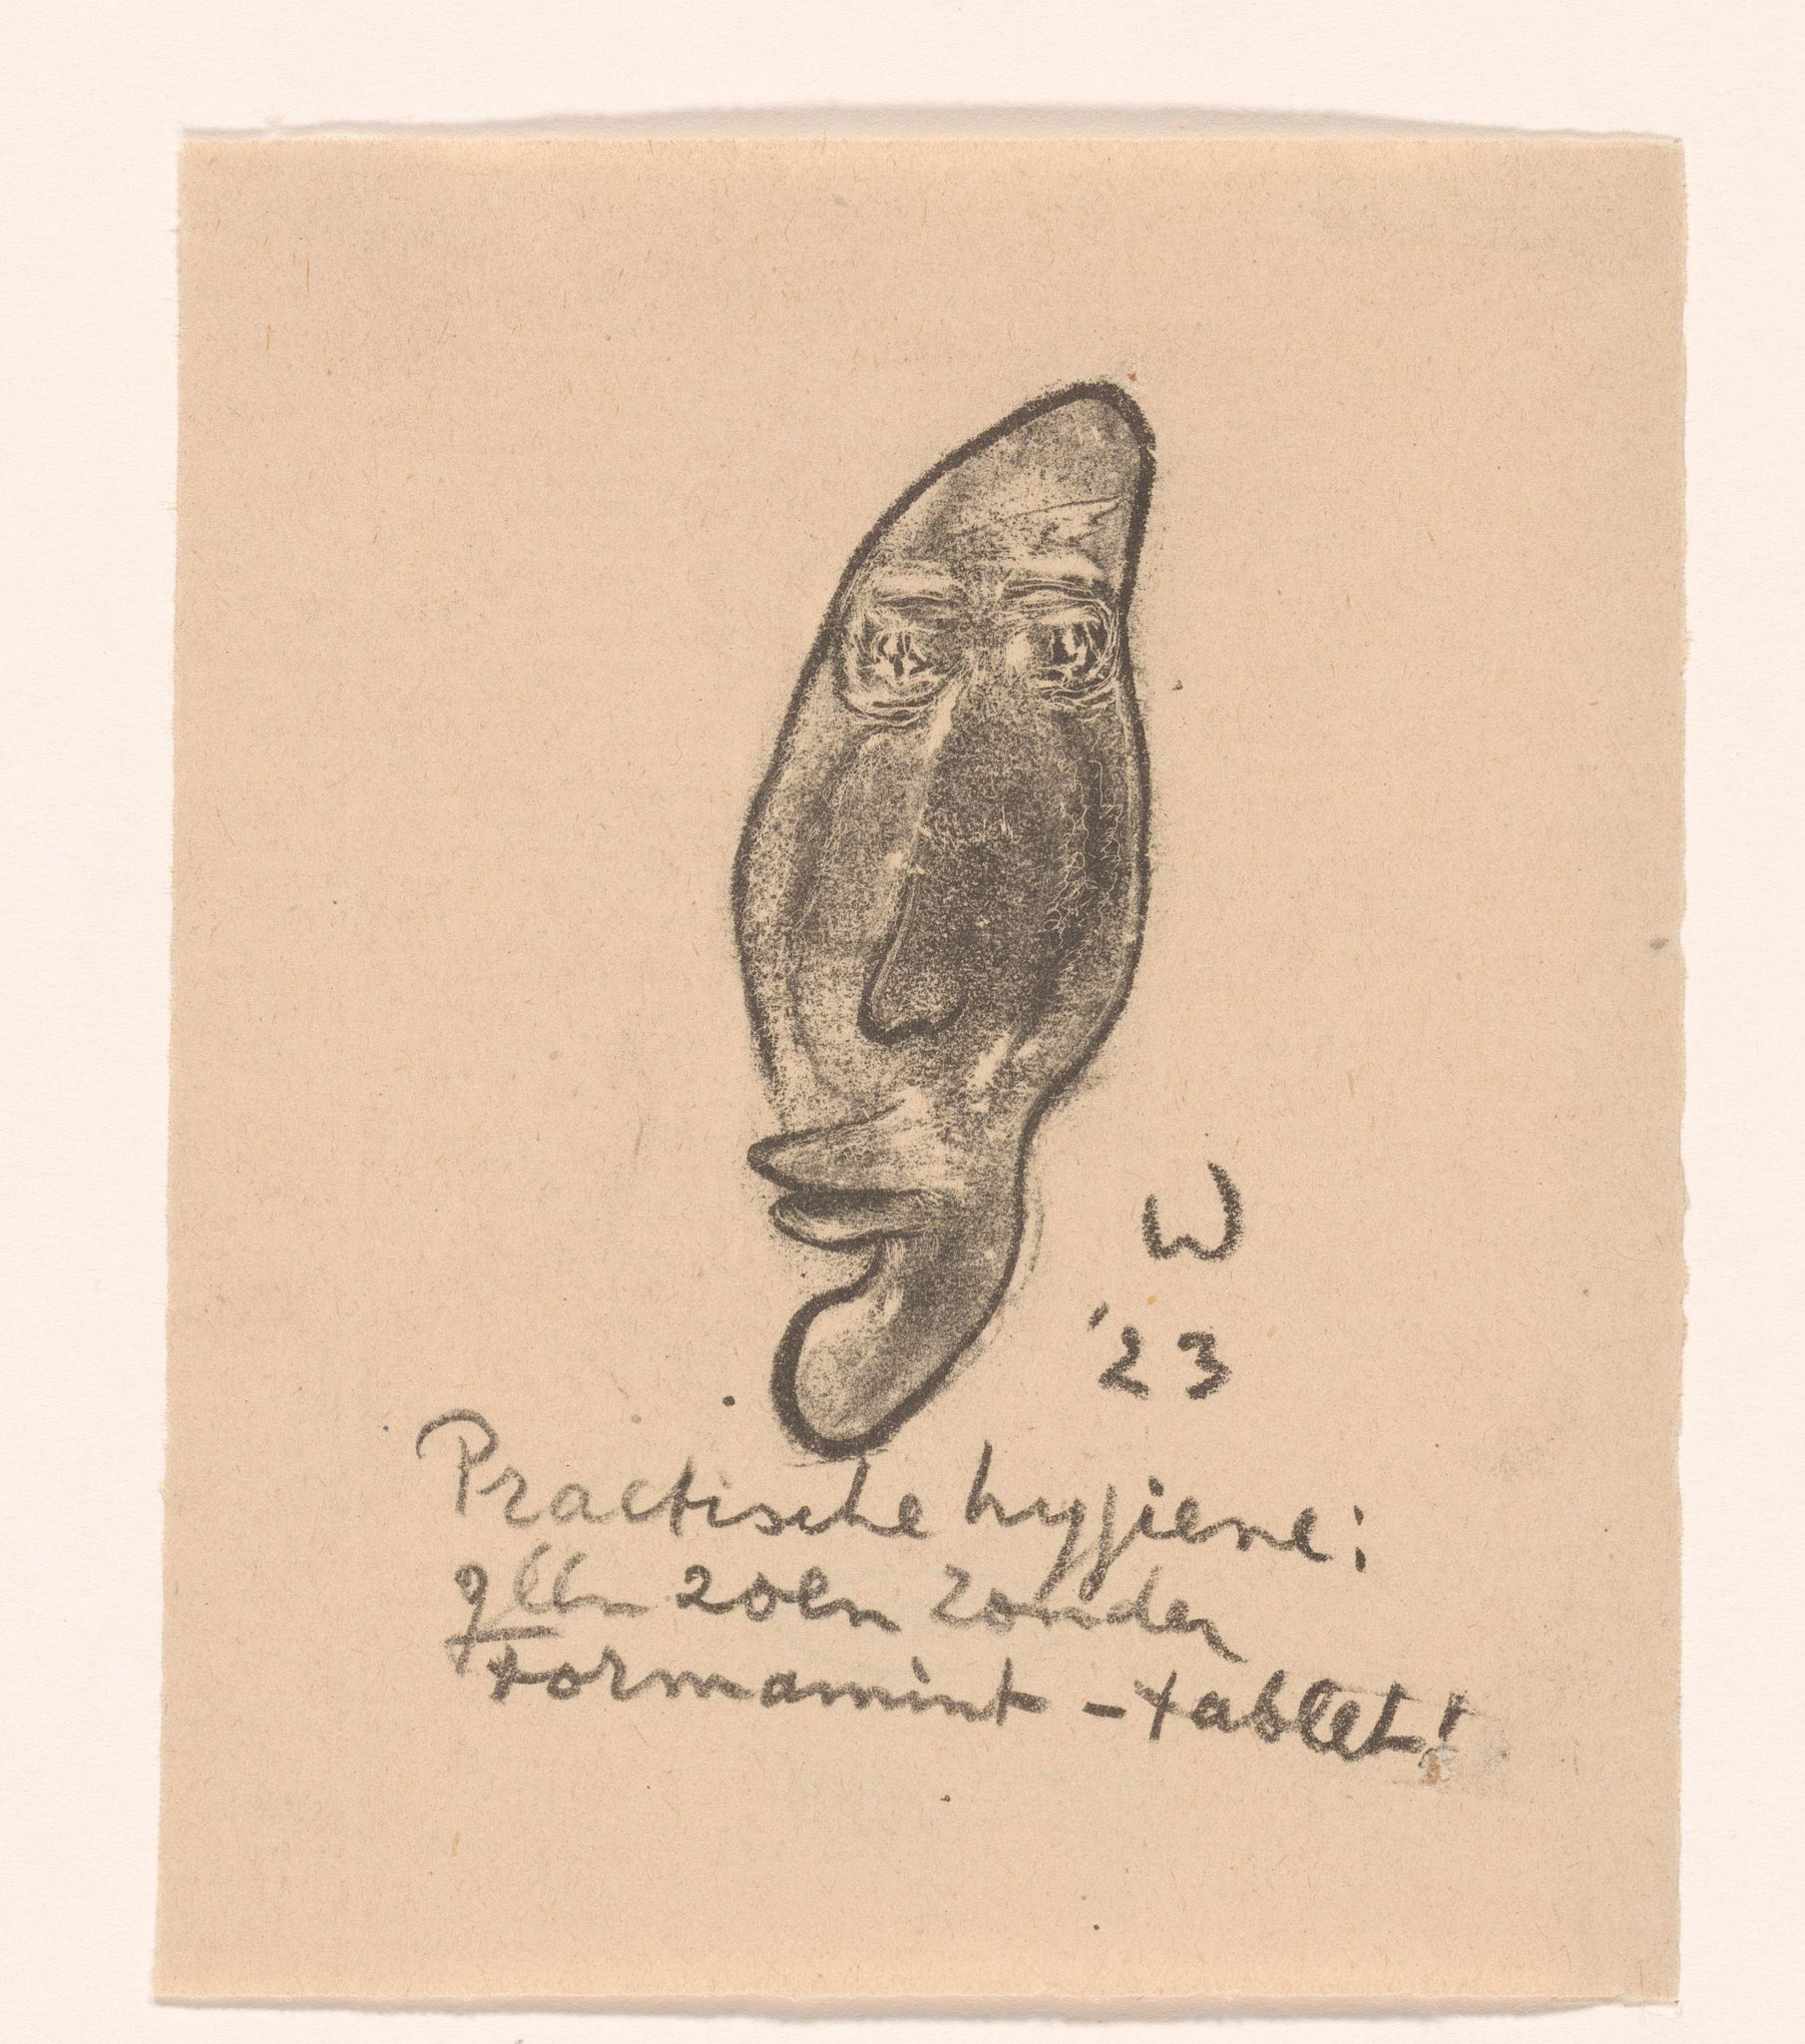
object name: print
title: Idealisten II en verdere Kanttekeningen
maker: erich wichmann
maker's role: print maker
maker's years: 1890-1929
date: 1923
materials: paper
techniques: lithograph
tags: caricatures (human types), embracing each other, kissing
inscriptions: collector's mark: Lugt 2228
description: Onderaan de tekst: 'Practische hygiene: géén zoen zonder Formamint-tablet!'